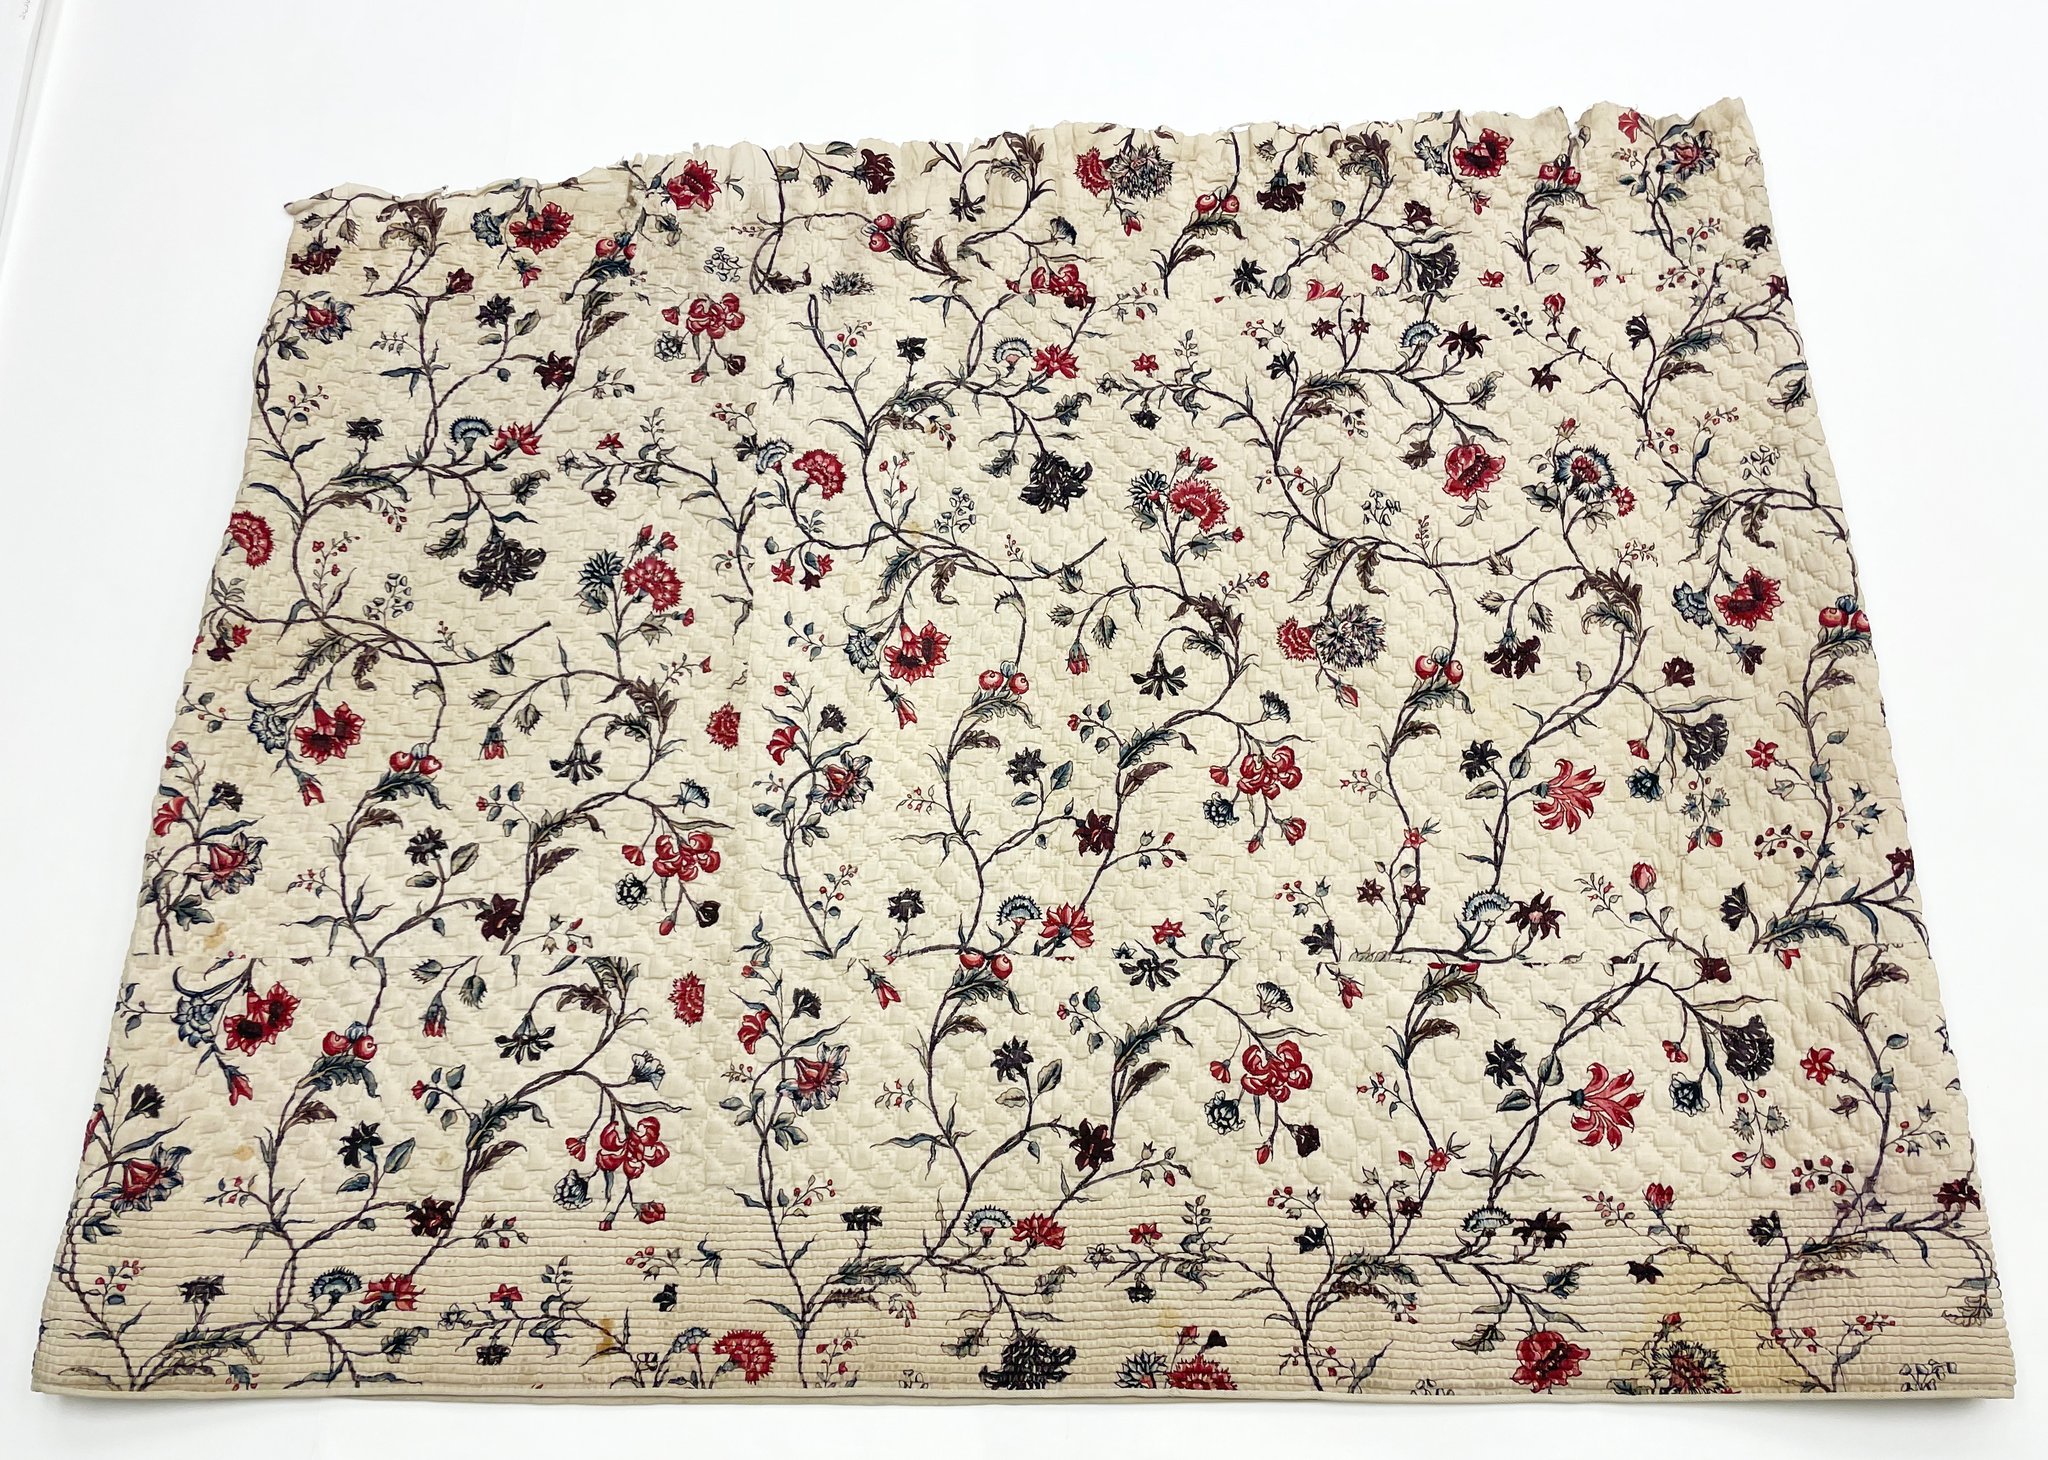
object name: floral print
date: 1783-1789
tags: flowers